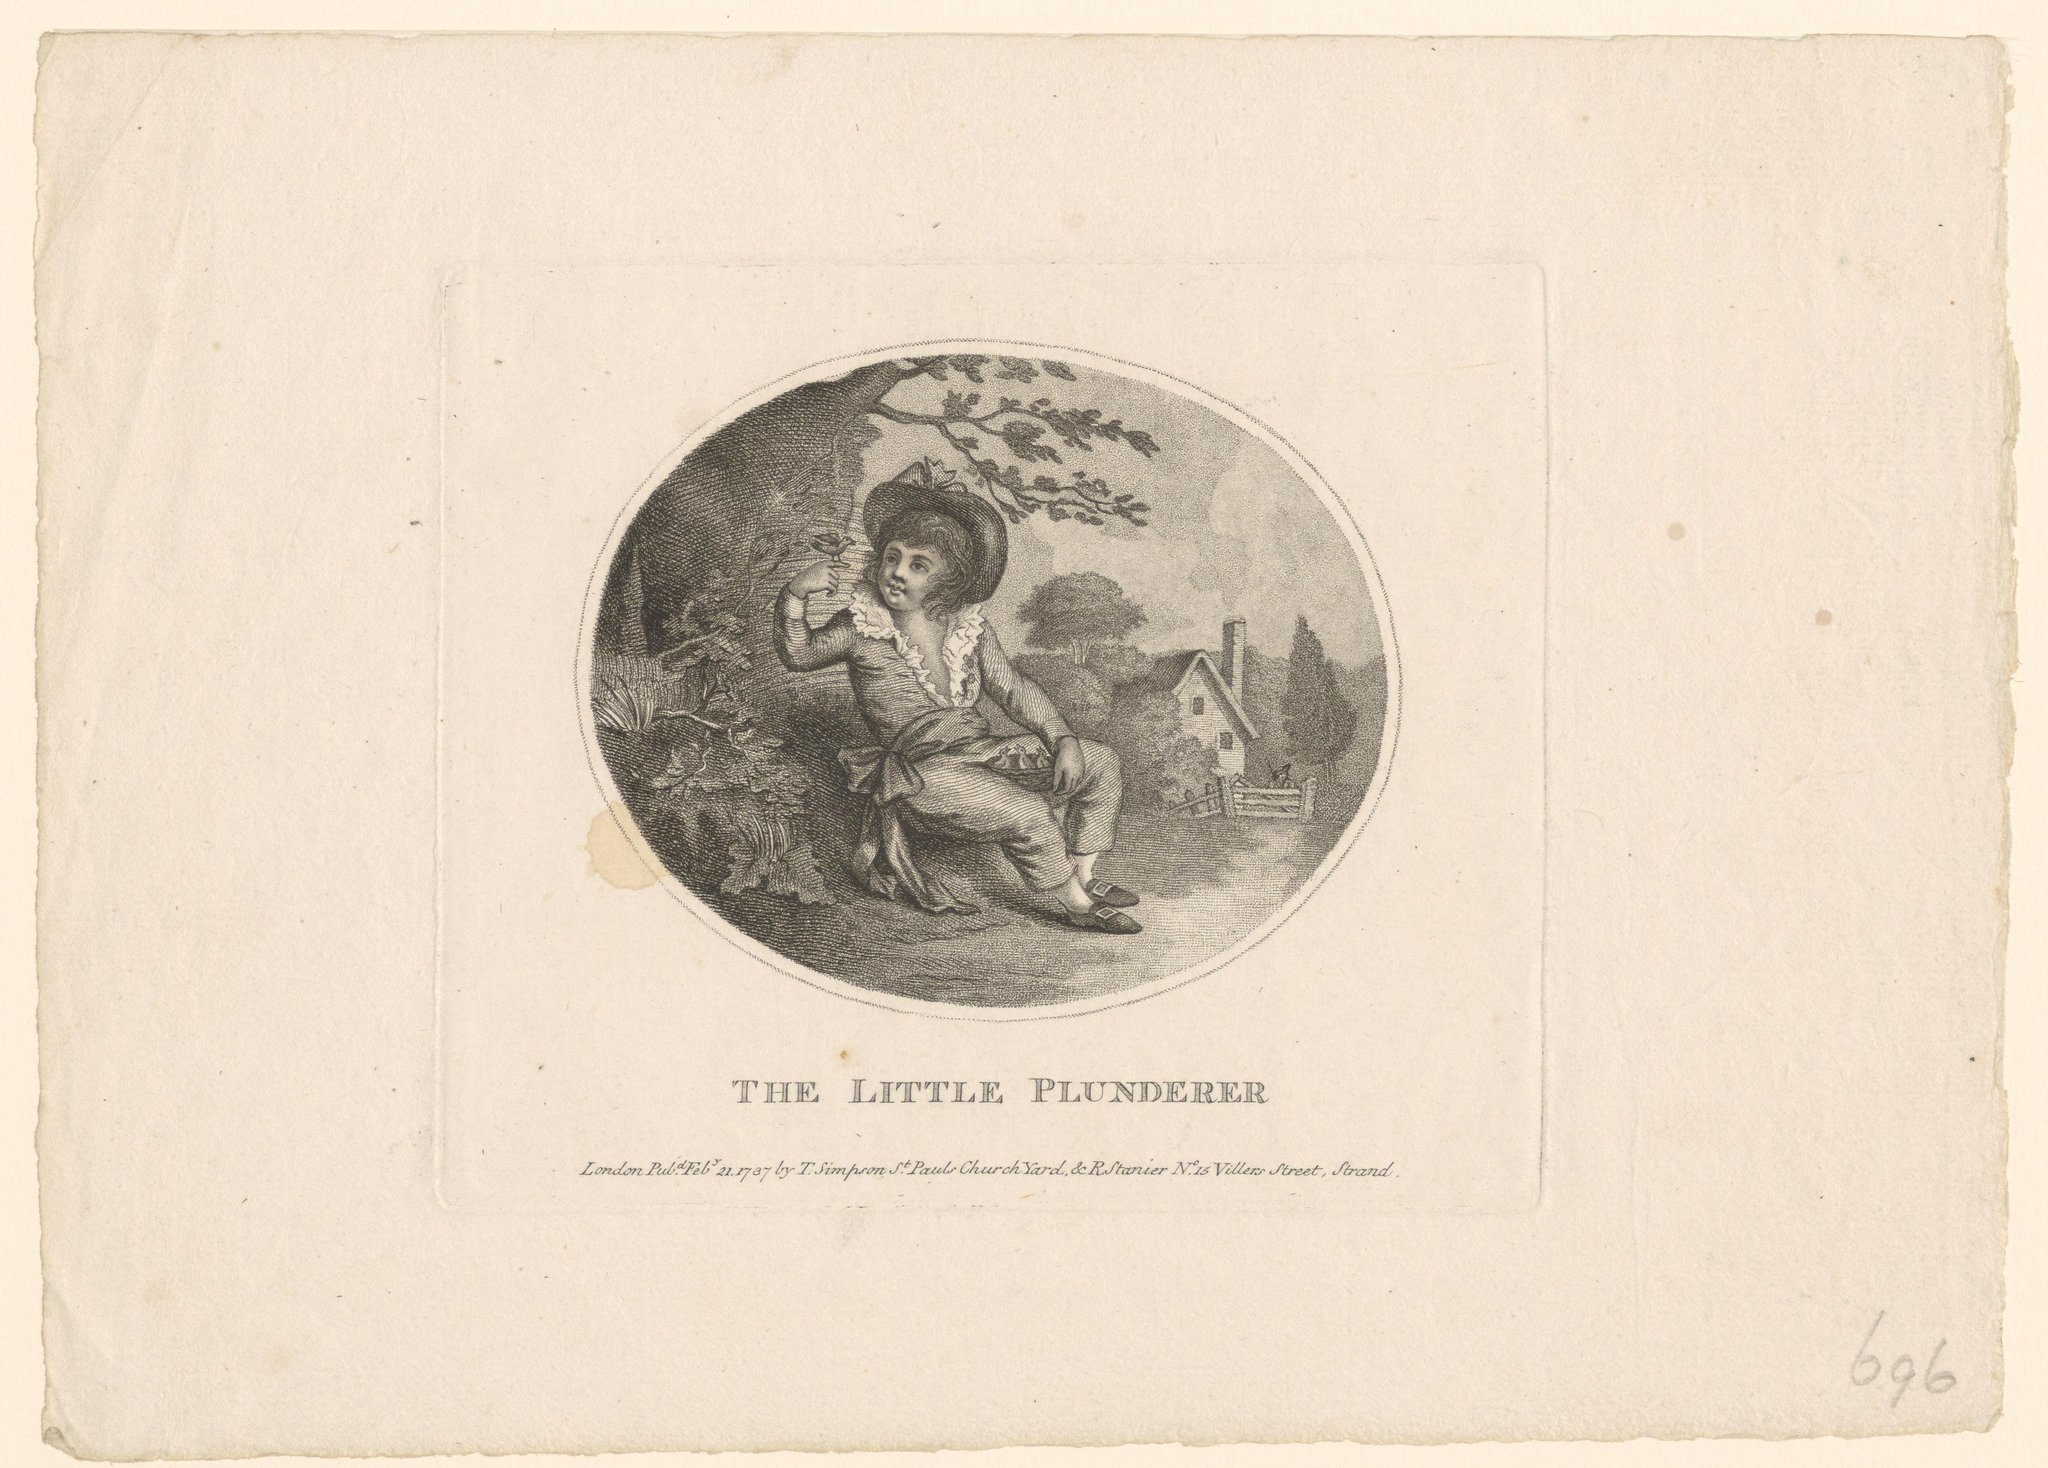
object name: print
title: Jongen met een vogelnest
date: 1787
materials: paper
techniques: engraving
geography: london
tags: caring for birds, playing toddler; child amusing itself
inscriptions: collector's mark: Lugt 2228